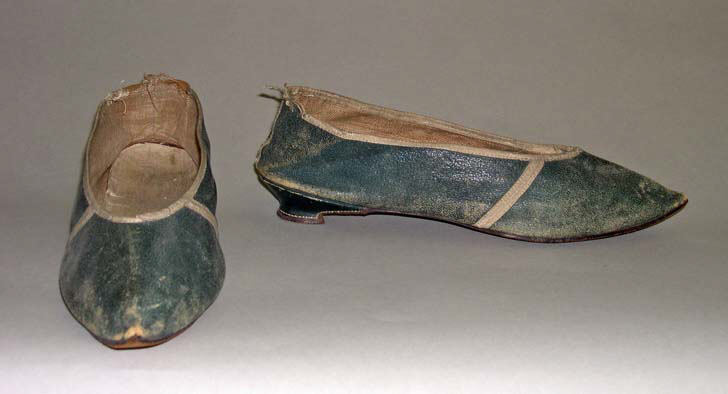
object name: slipper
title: Slippers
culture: british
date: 1785-1795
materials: leather, linen